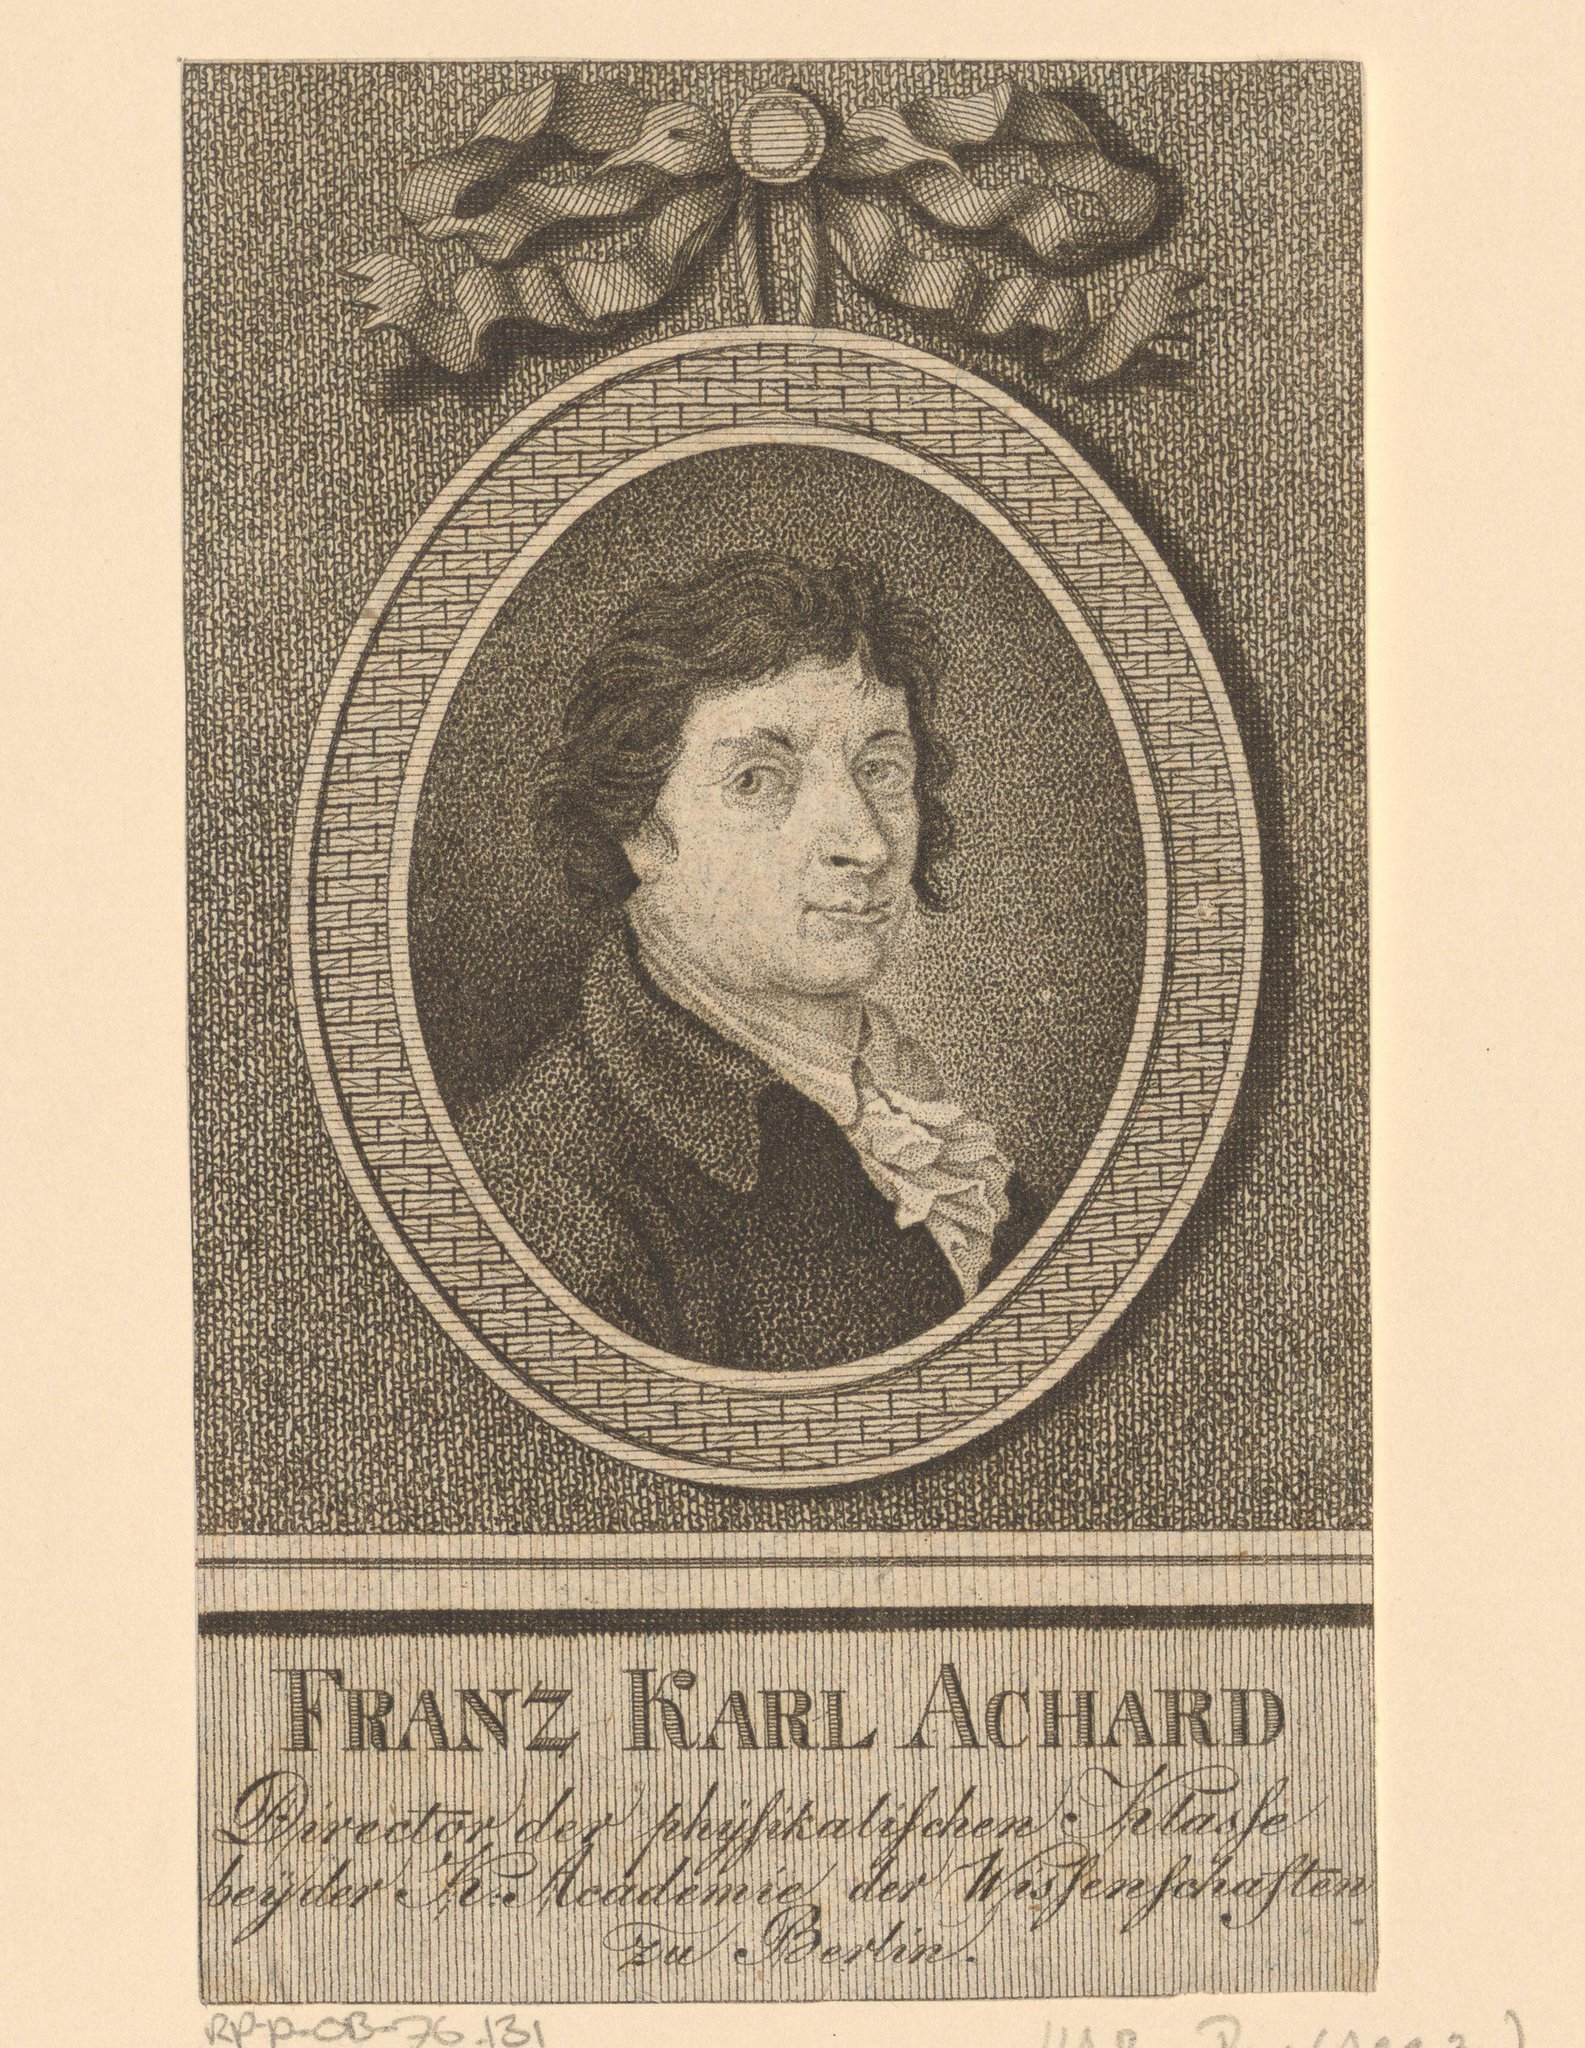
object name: print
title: Portret van Franz Carl Achard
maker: Anonymous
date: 1782-1849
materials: paper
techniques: etching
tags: berlin, physicist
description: Portret van Franz Carl Achard in een ovale omlijsting. In de ondermarge zijn naam en zijn beroep.